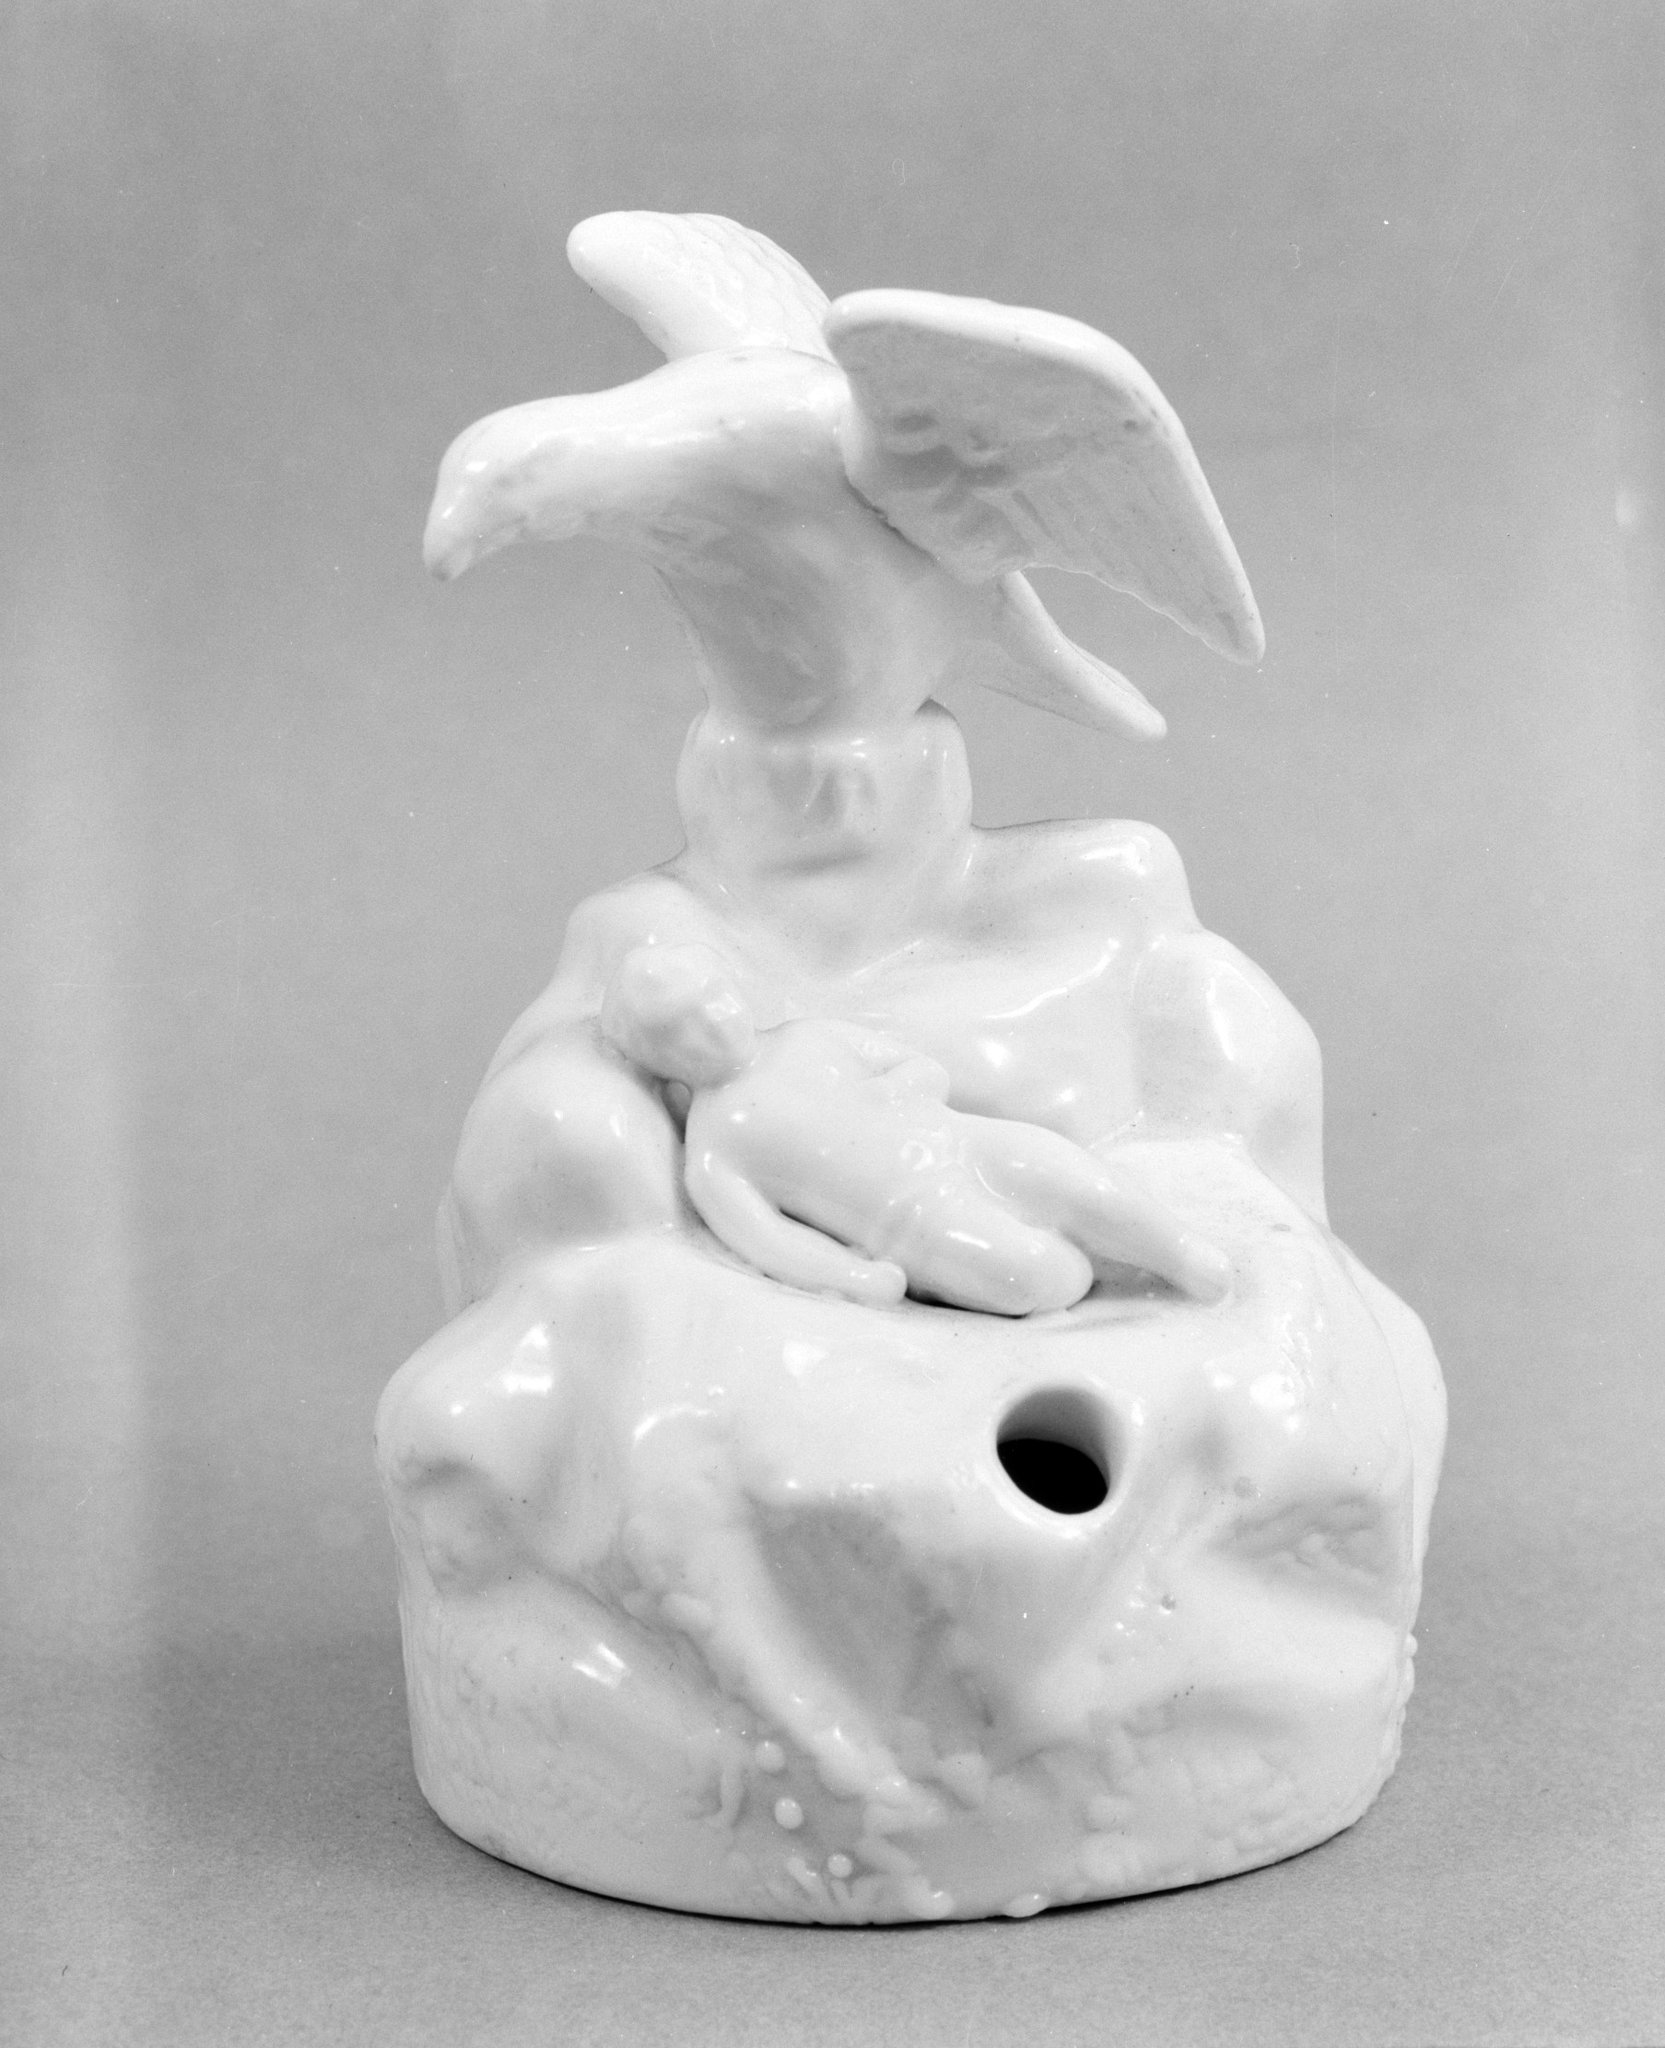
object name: inkwell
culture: american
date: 1830-1870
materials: porcelain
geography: united states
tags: eagles,children